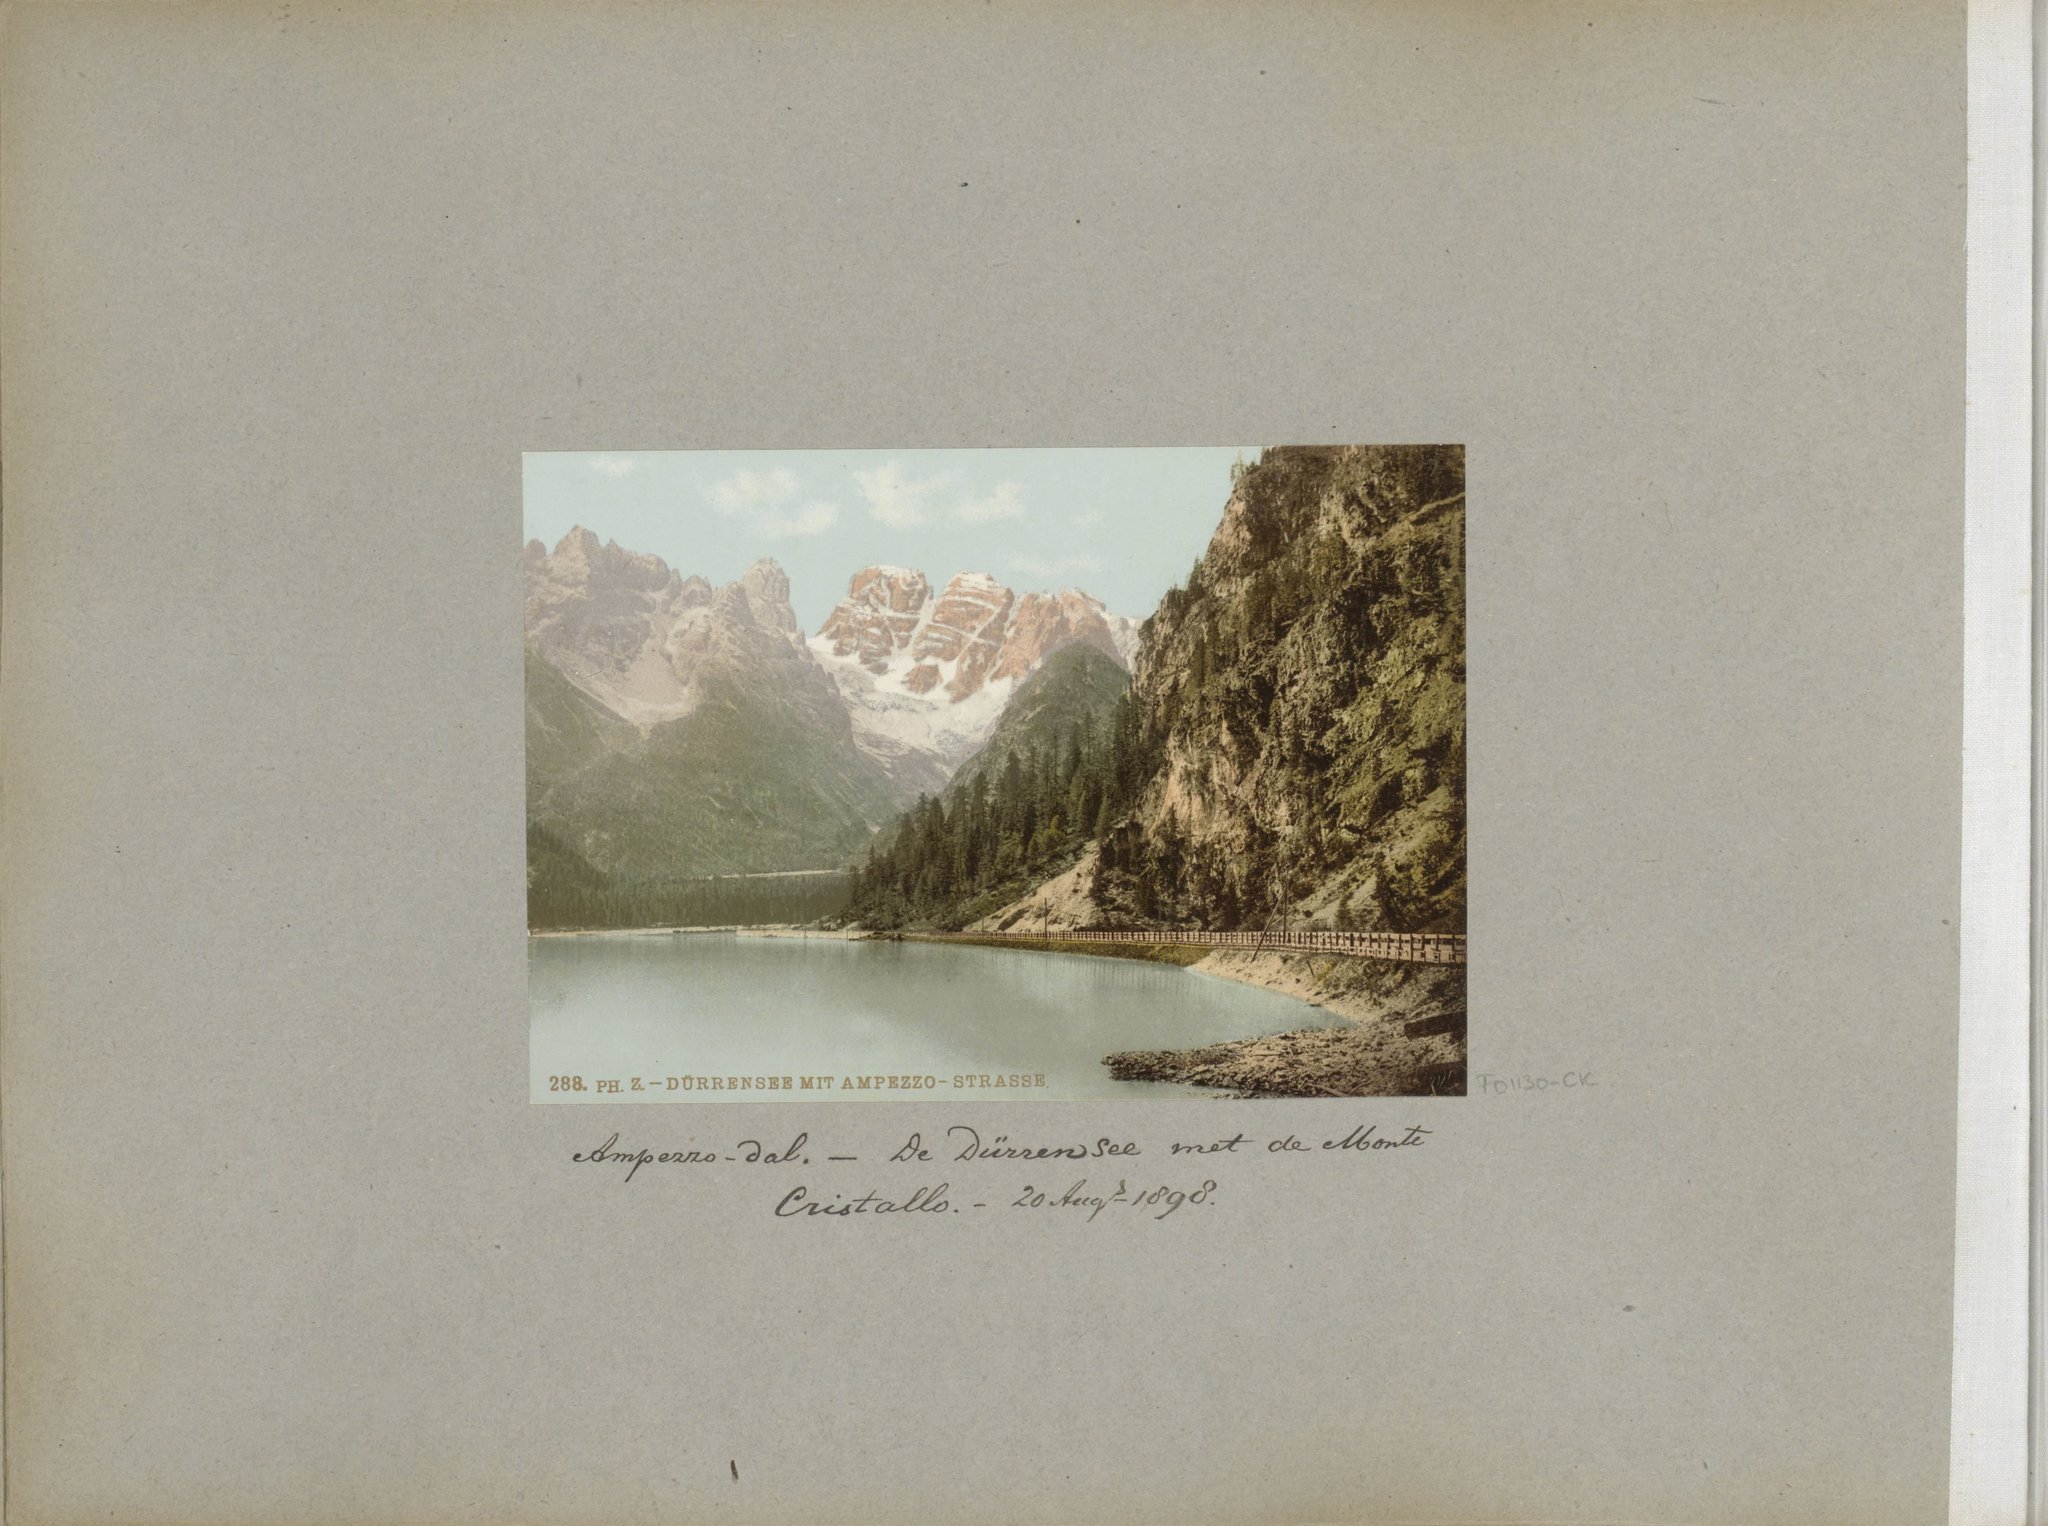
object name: album leaf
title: Dürrensee mit Ampezzo-strasse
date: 1880-1898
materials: ink, paper, photographic process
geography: tirol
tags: mountain-top, peak (+ landscape with figures, staffage), lake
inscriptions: number: ‘288’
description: Onderdeel van Reisalbum met foto's van bezienswaardigheden in Frankrijk, Spanje, Italië, Duitsland, Zwitserland en Oostenrijk.